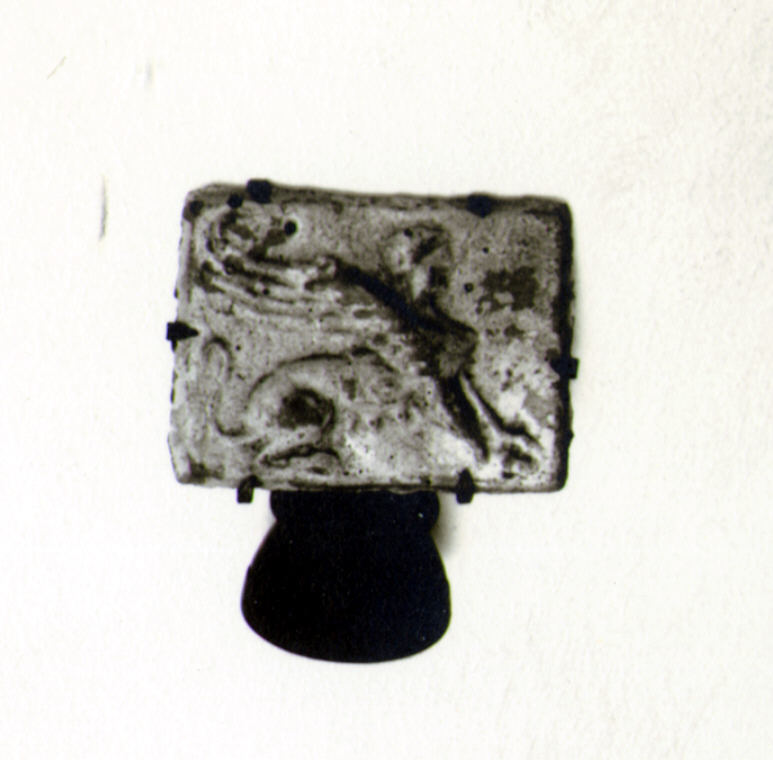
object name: plaque of sphinx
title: Glass plaque with sphinx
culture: roman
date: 1-100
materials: glass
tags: sphinx